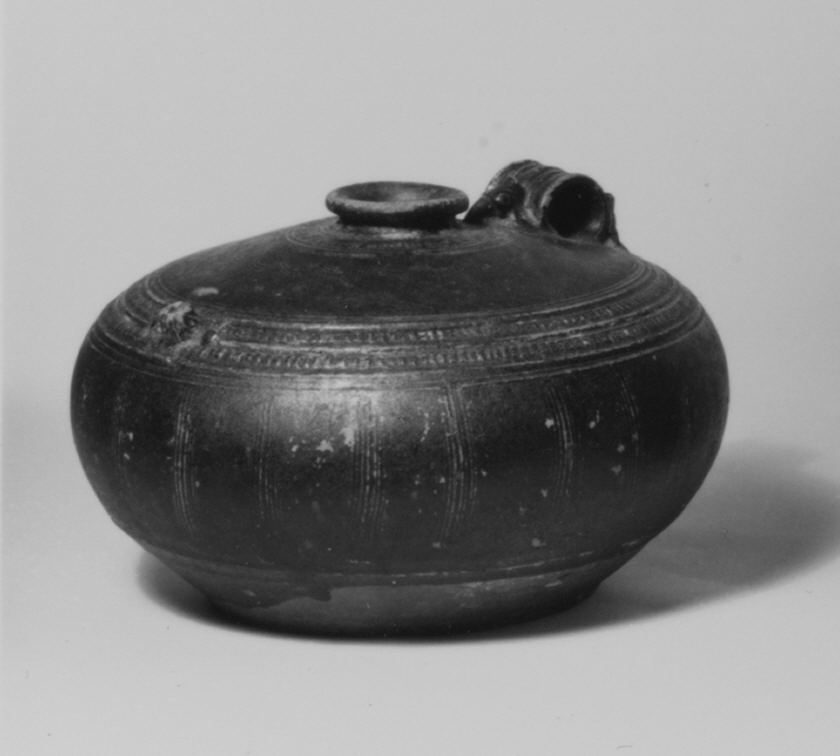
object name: jar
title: Jar with Zoomorphic Handle and Spout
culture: thai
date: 1067-1200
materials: stoneware